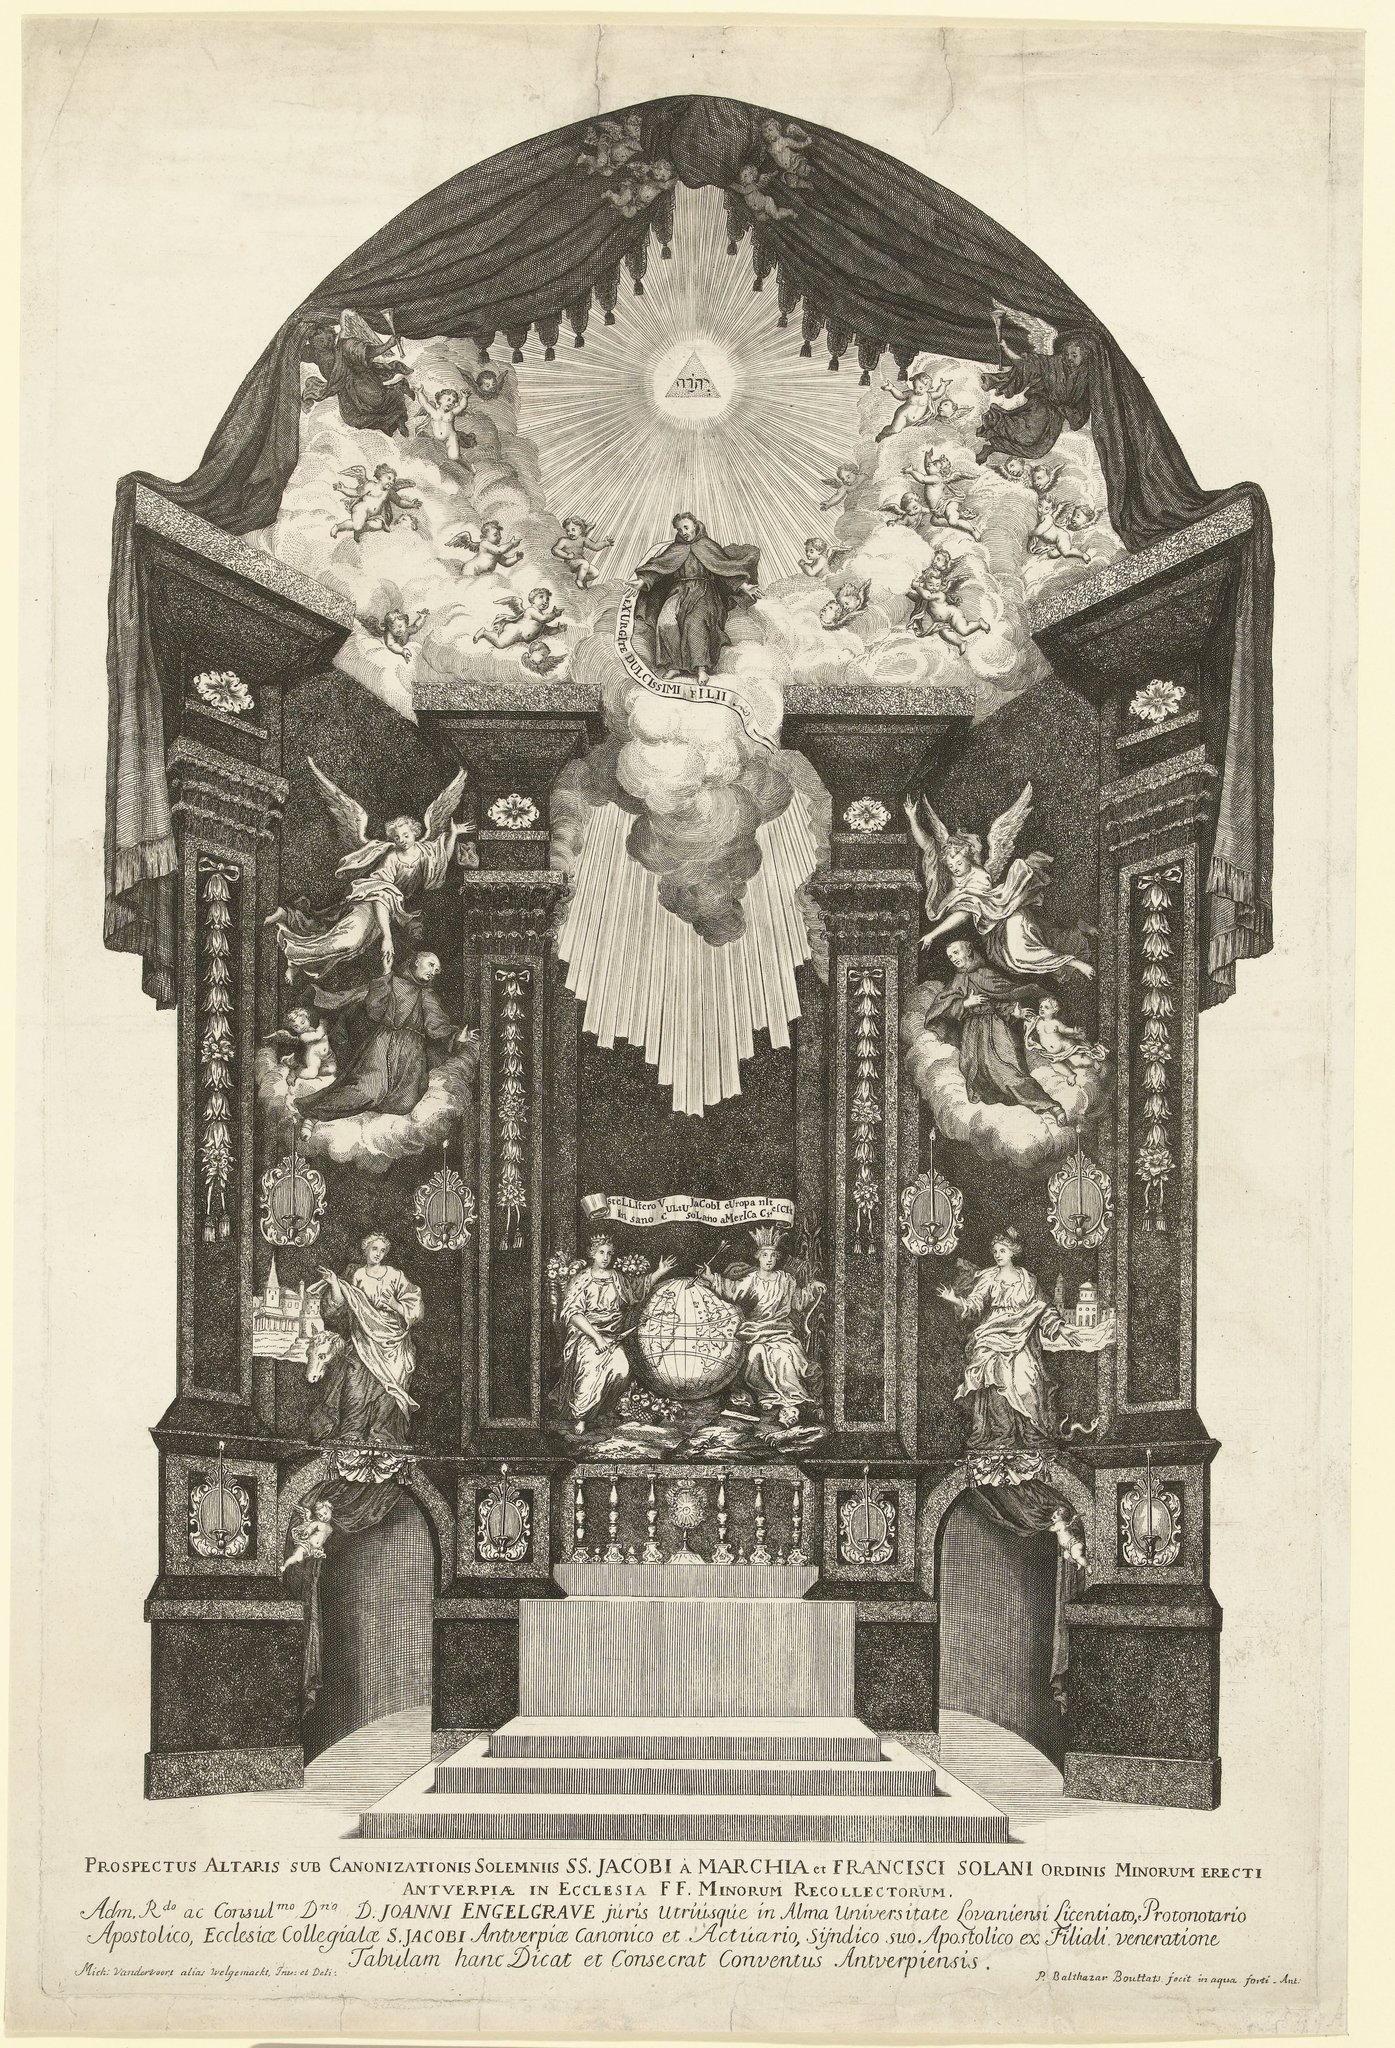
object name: print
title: Prospectus Altaris sub Canonizationis Solemniis SS Jacobi à Marchia et Francisci Solani Ordinis Minorum Erecti Antverpiae in Ecclesia FF Minorum Recollectorum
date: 1726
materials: paper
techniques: engraving, etching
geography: antwerp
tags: naples, fixed altar, antwerp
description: Altaar ter gelegenheid van de heiligverklaring van de franciscanen Jacobus de Marchia en Franciscus Solanus in 1726, opgericht in de kerk van de franciscaner minderboeders te Antwerpen. Met onderschrift van 5 regels in het Latijn.